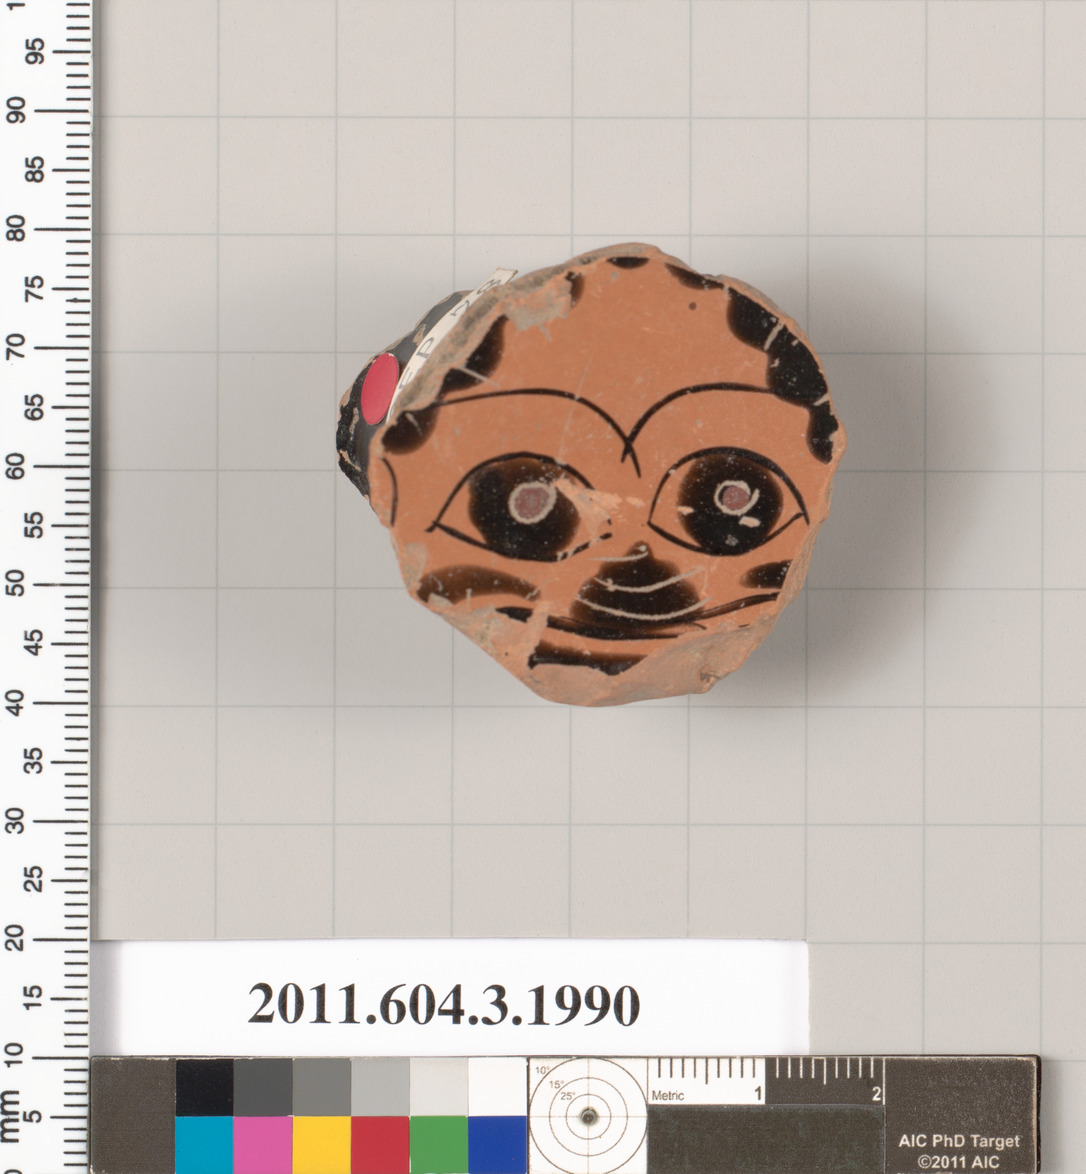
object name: kylix fragment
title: Terracotta fragment of a kylix (drinking cup)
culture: greek, attic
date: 550-526 BCE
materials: terracotta